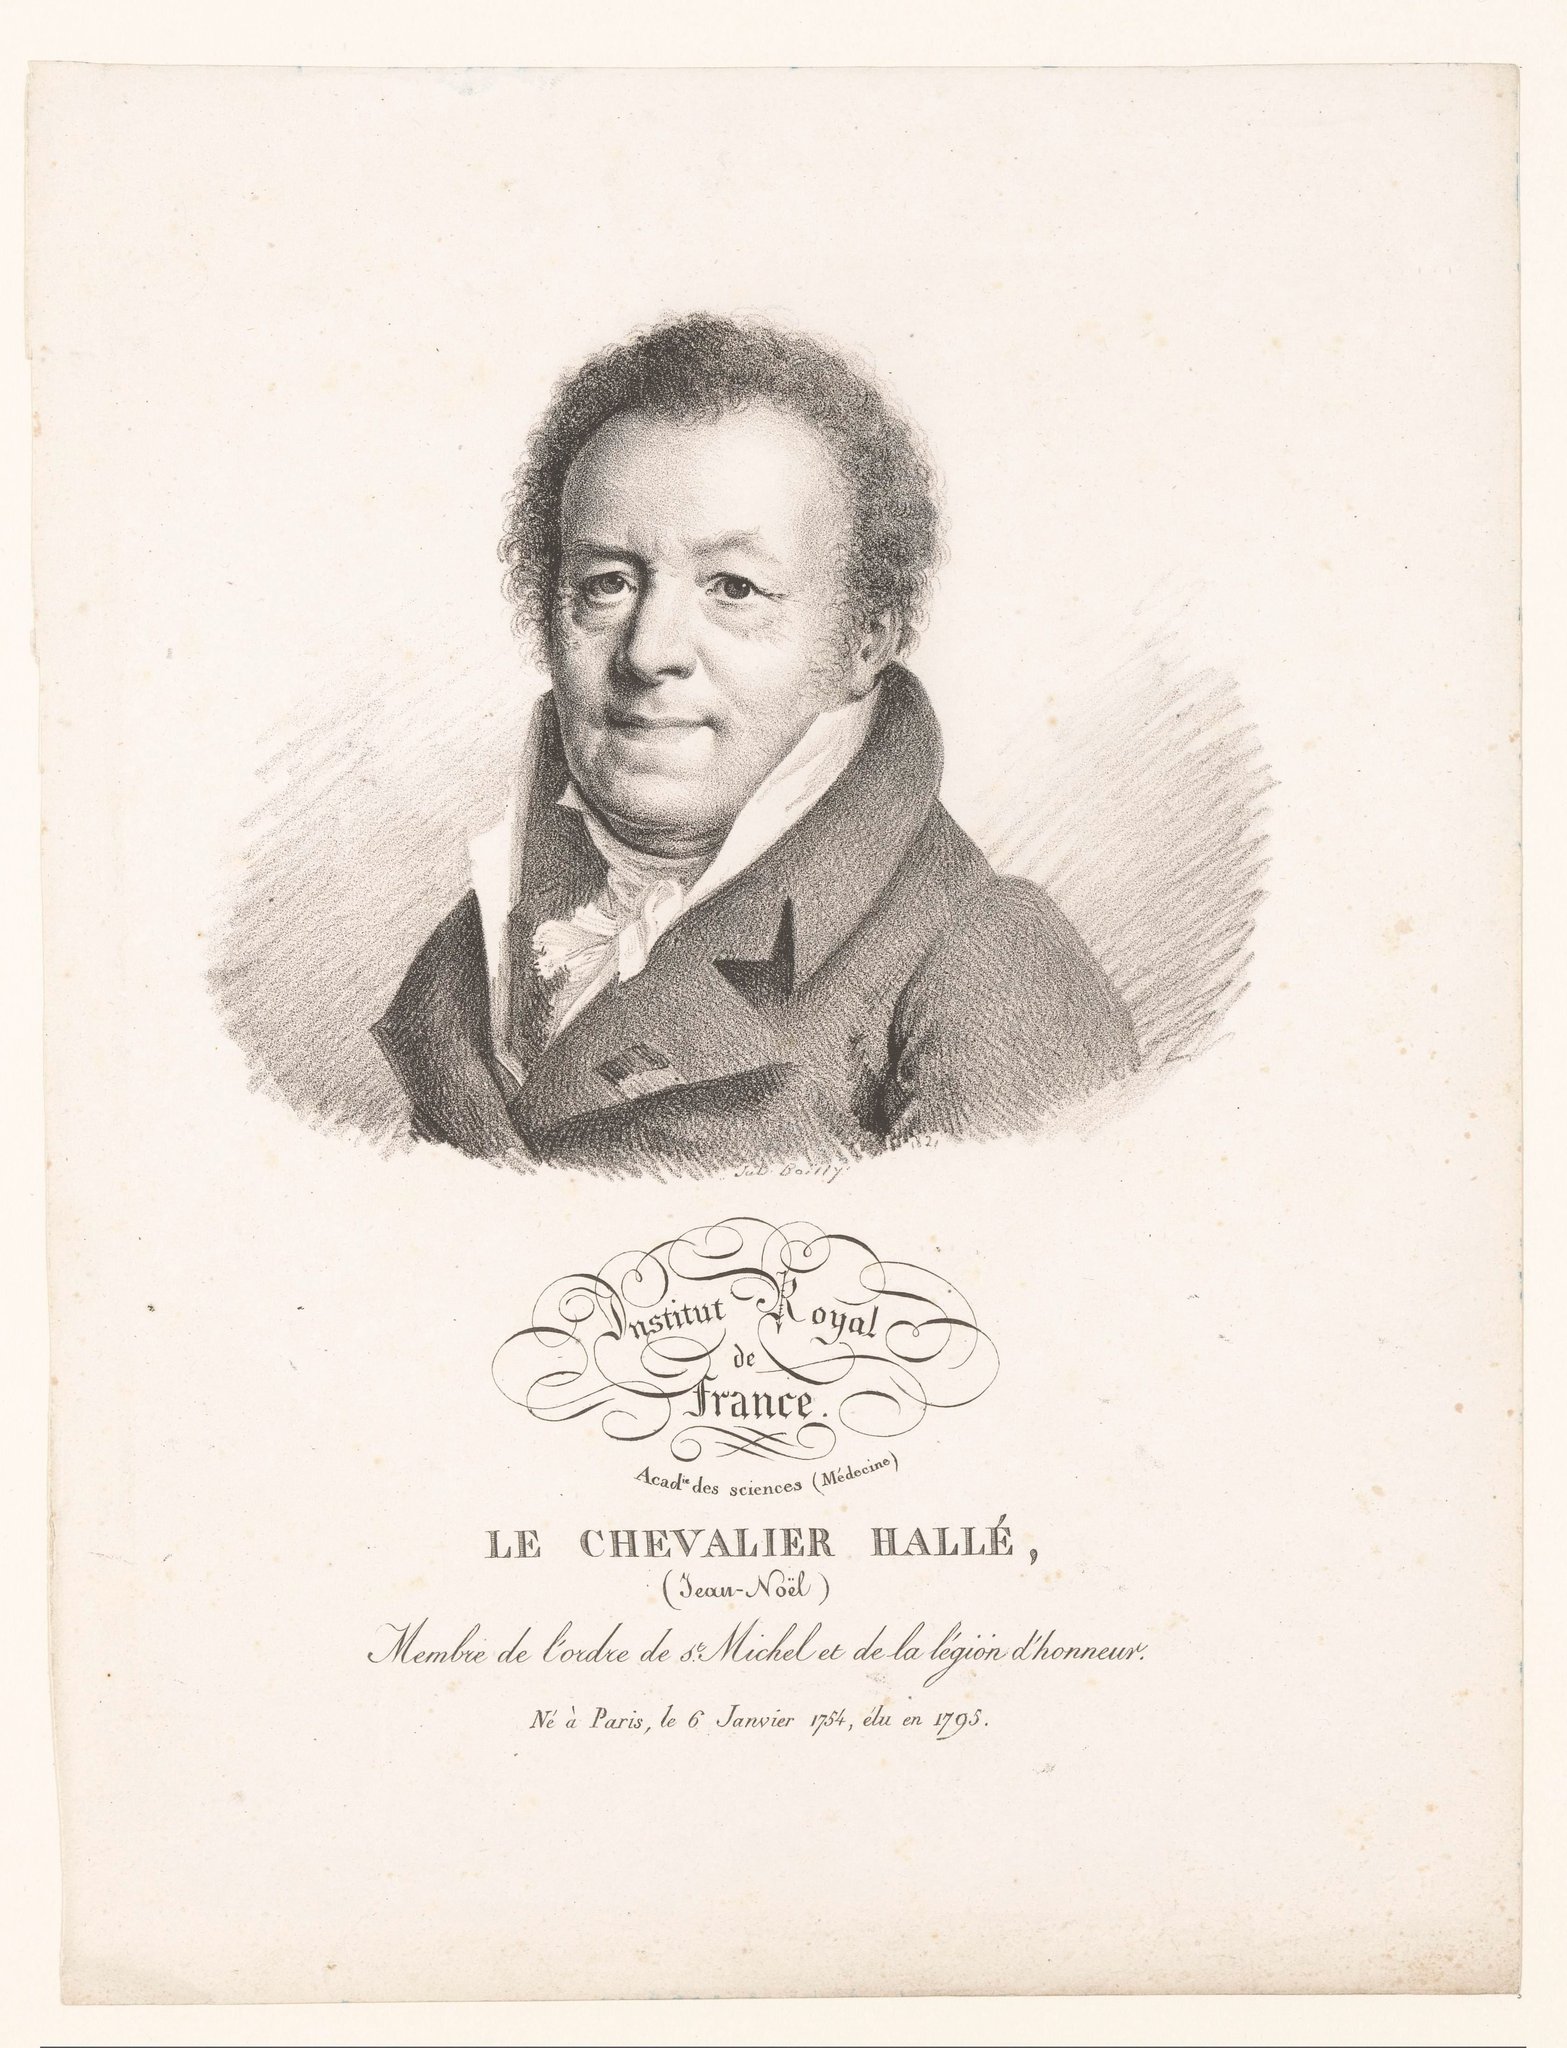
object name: print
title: Le Chevalier Hallé, Jean-Noël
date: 1821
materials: paper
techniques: lithograph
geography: paris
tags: paris, historical persons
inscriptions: collector's mark: Lugt 2228a